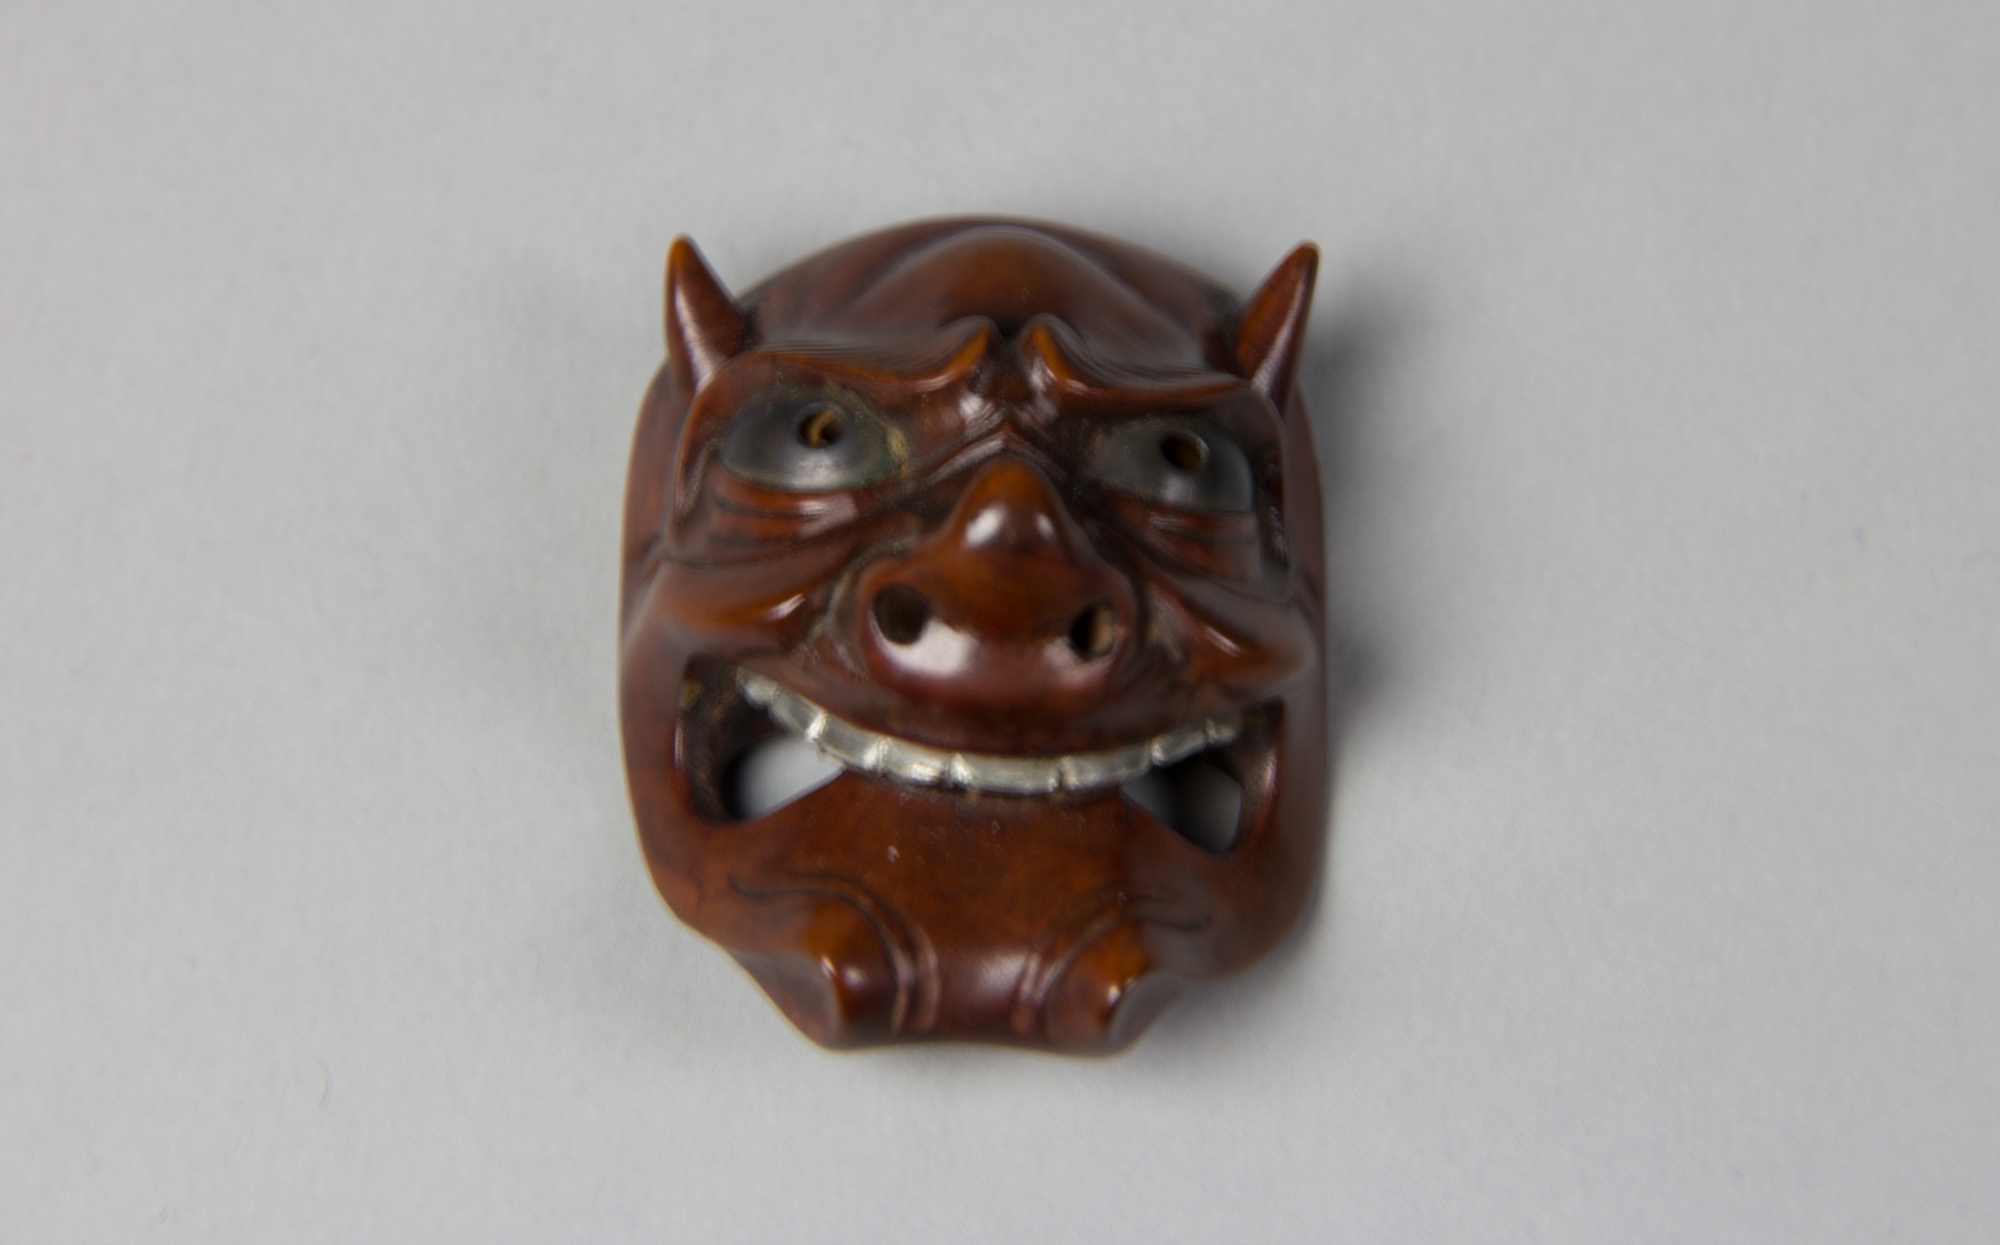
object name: netsuke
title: Netsuke of Noh Mask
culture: japanese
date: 1801-1900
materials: metal, wood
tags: masks